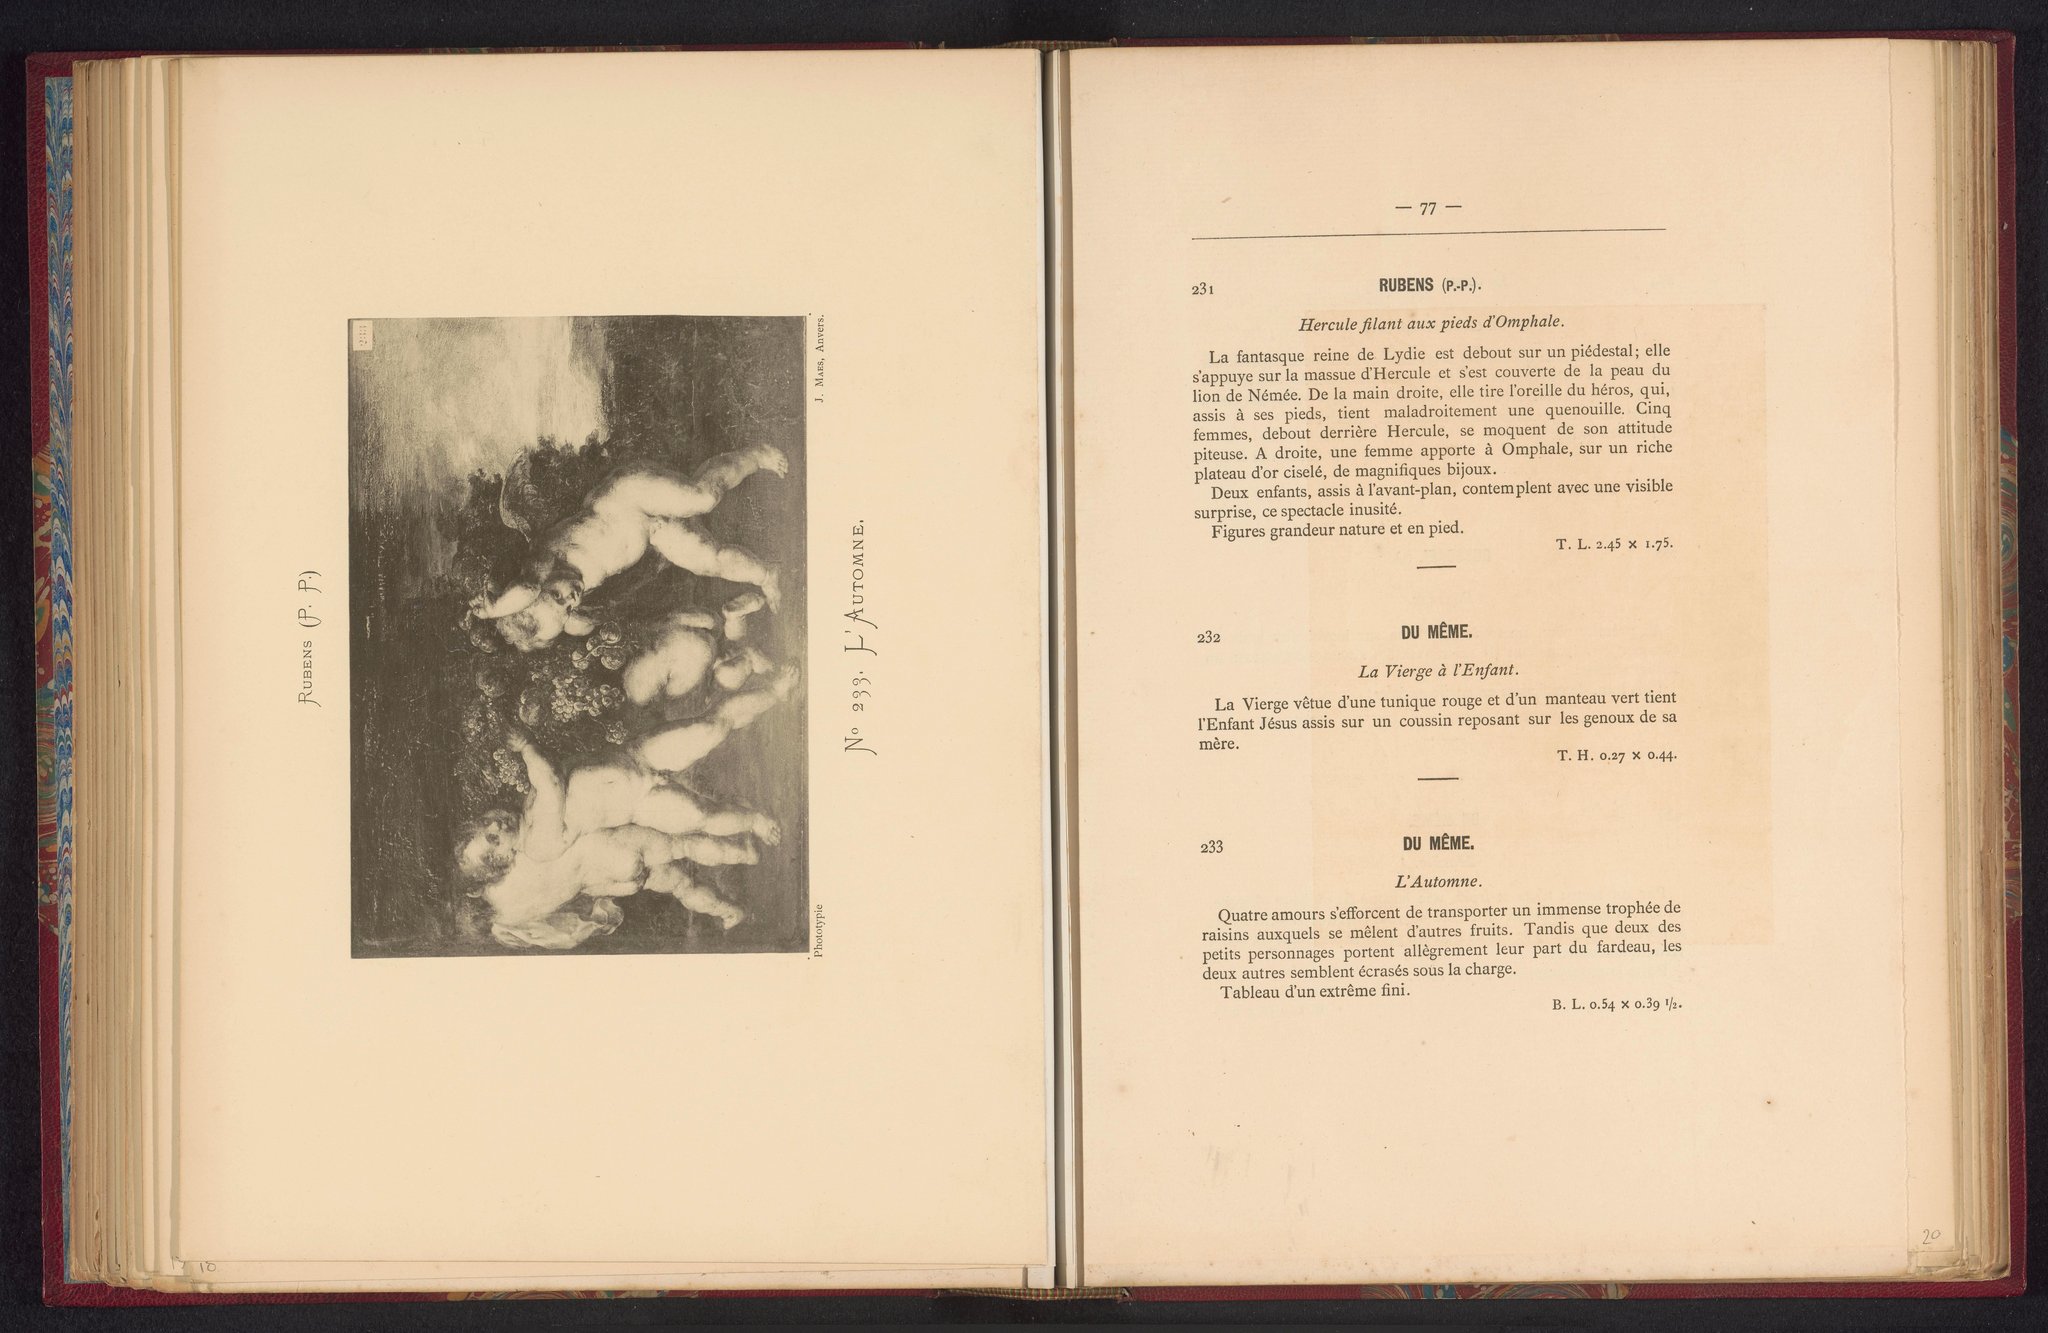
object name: page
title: Reproductie van een schilderij van kinderen van Peter Paul Rubens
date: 1878-1883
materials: paper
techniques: photograph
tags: infant, baby, painting, drawing and the graphic arts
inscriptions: number: ‘No. 233’